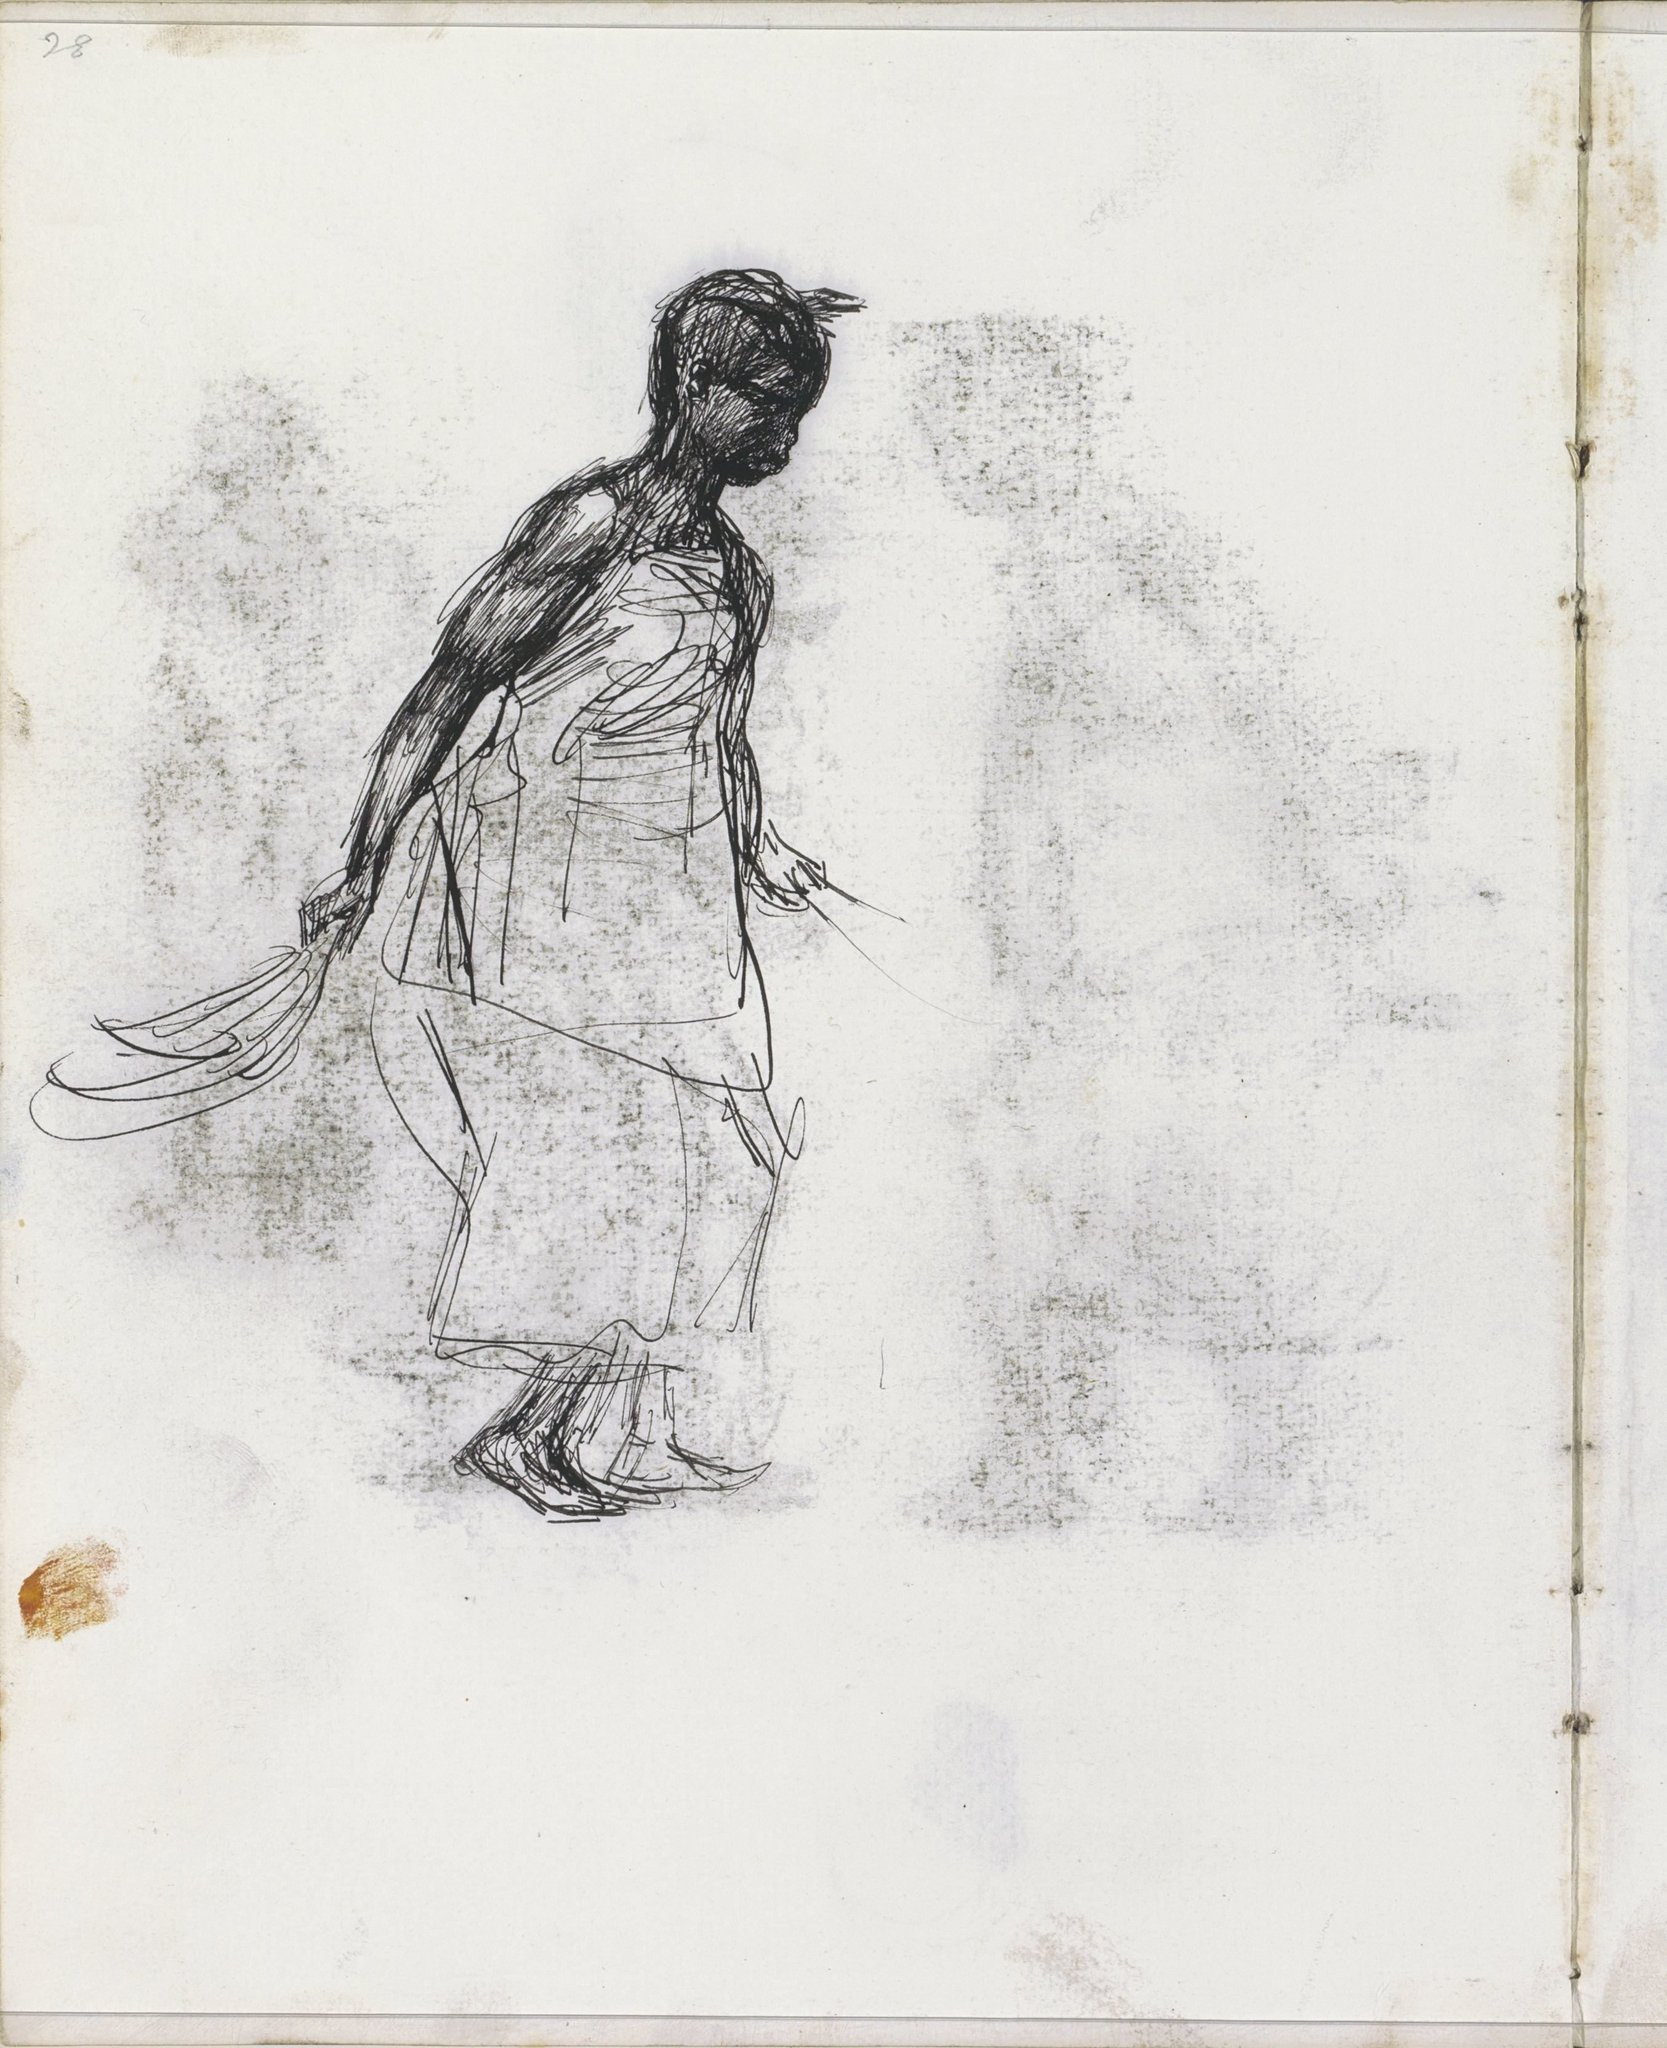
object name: sketchbook leaf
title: Afrikaanse vrouw, mogelijk een danseres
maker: isaac israels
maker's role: draughtsman, painter, print maker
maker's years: 1865-1934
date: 1875-1934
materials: ink, paper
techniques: pen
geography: the hague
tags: leaning forward, dancing, africans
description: Blad 15 verso uit schetsboek XIII met 25 bladen.